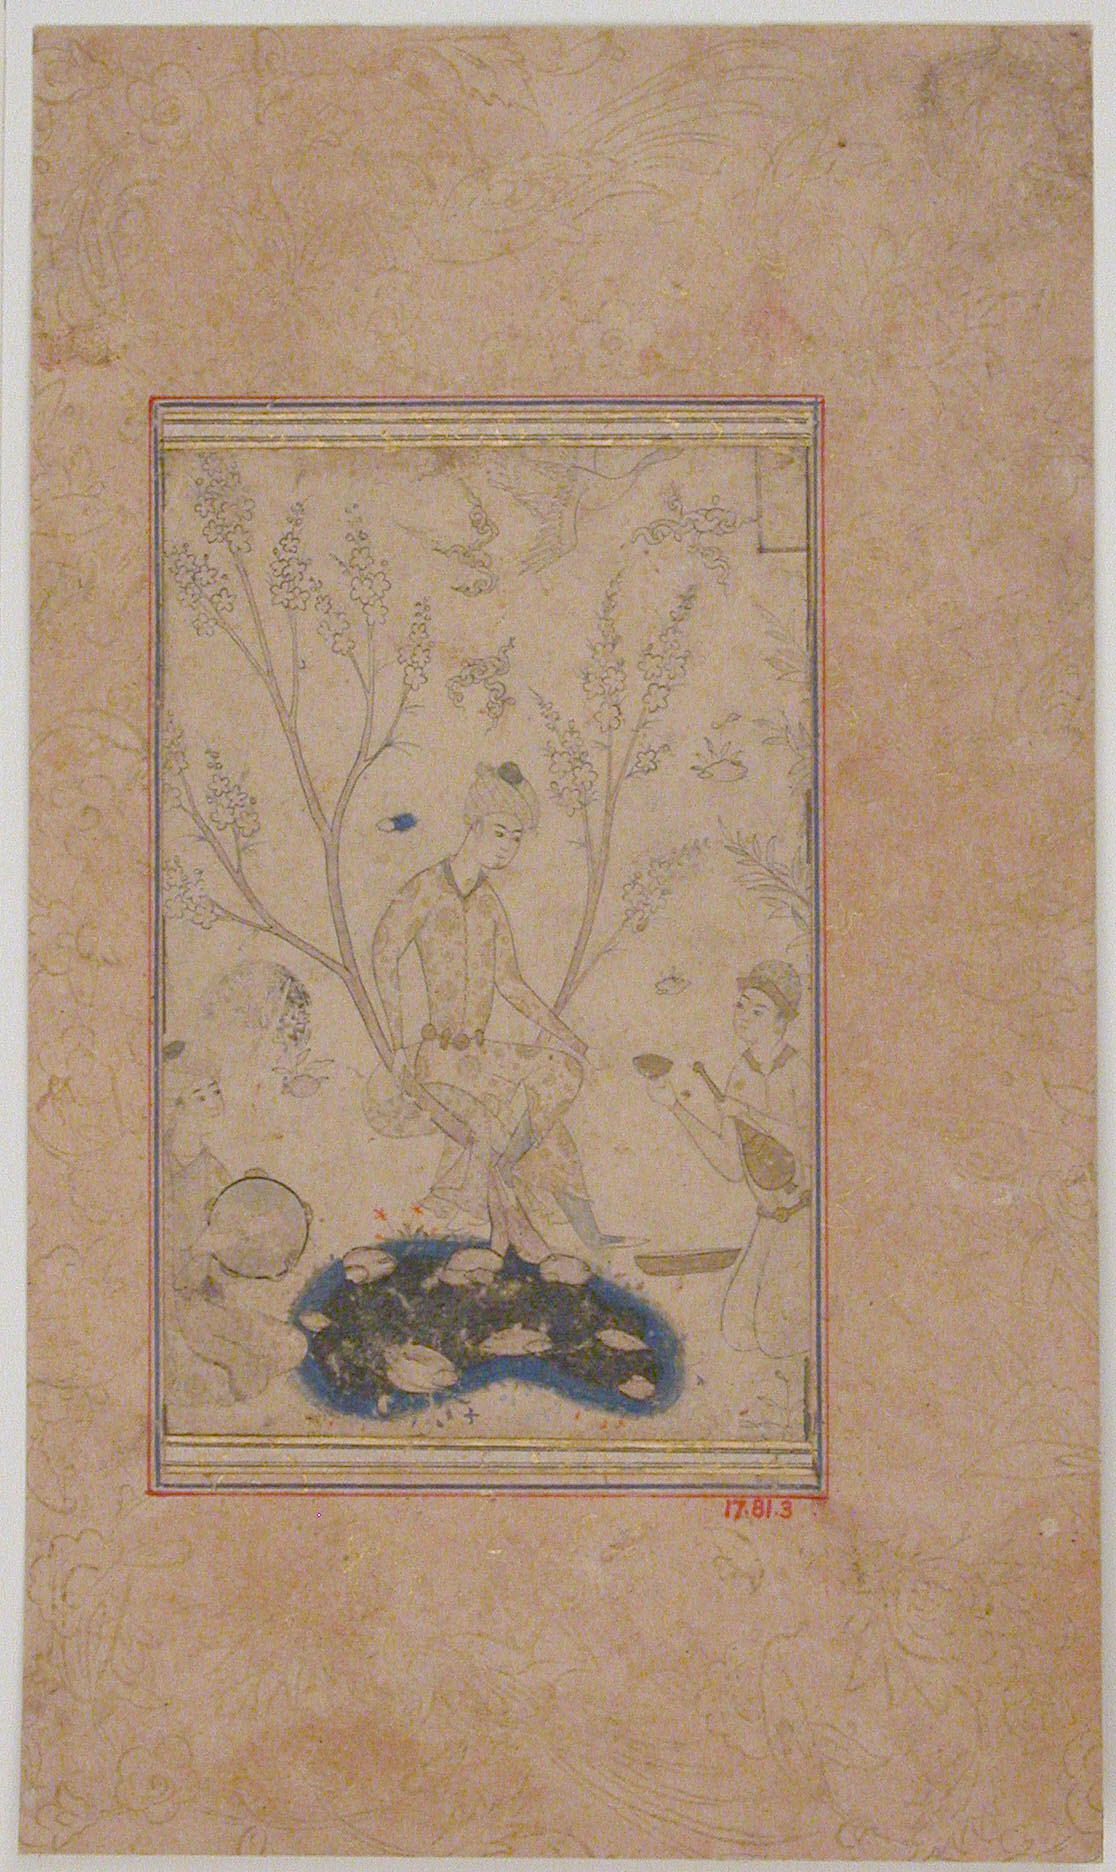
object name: illustrated single work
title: A Gentleman with His Musicians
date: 1534-1566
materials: ink, paper, watercolor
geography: iran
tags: men,trees,musicians